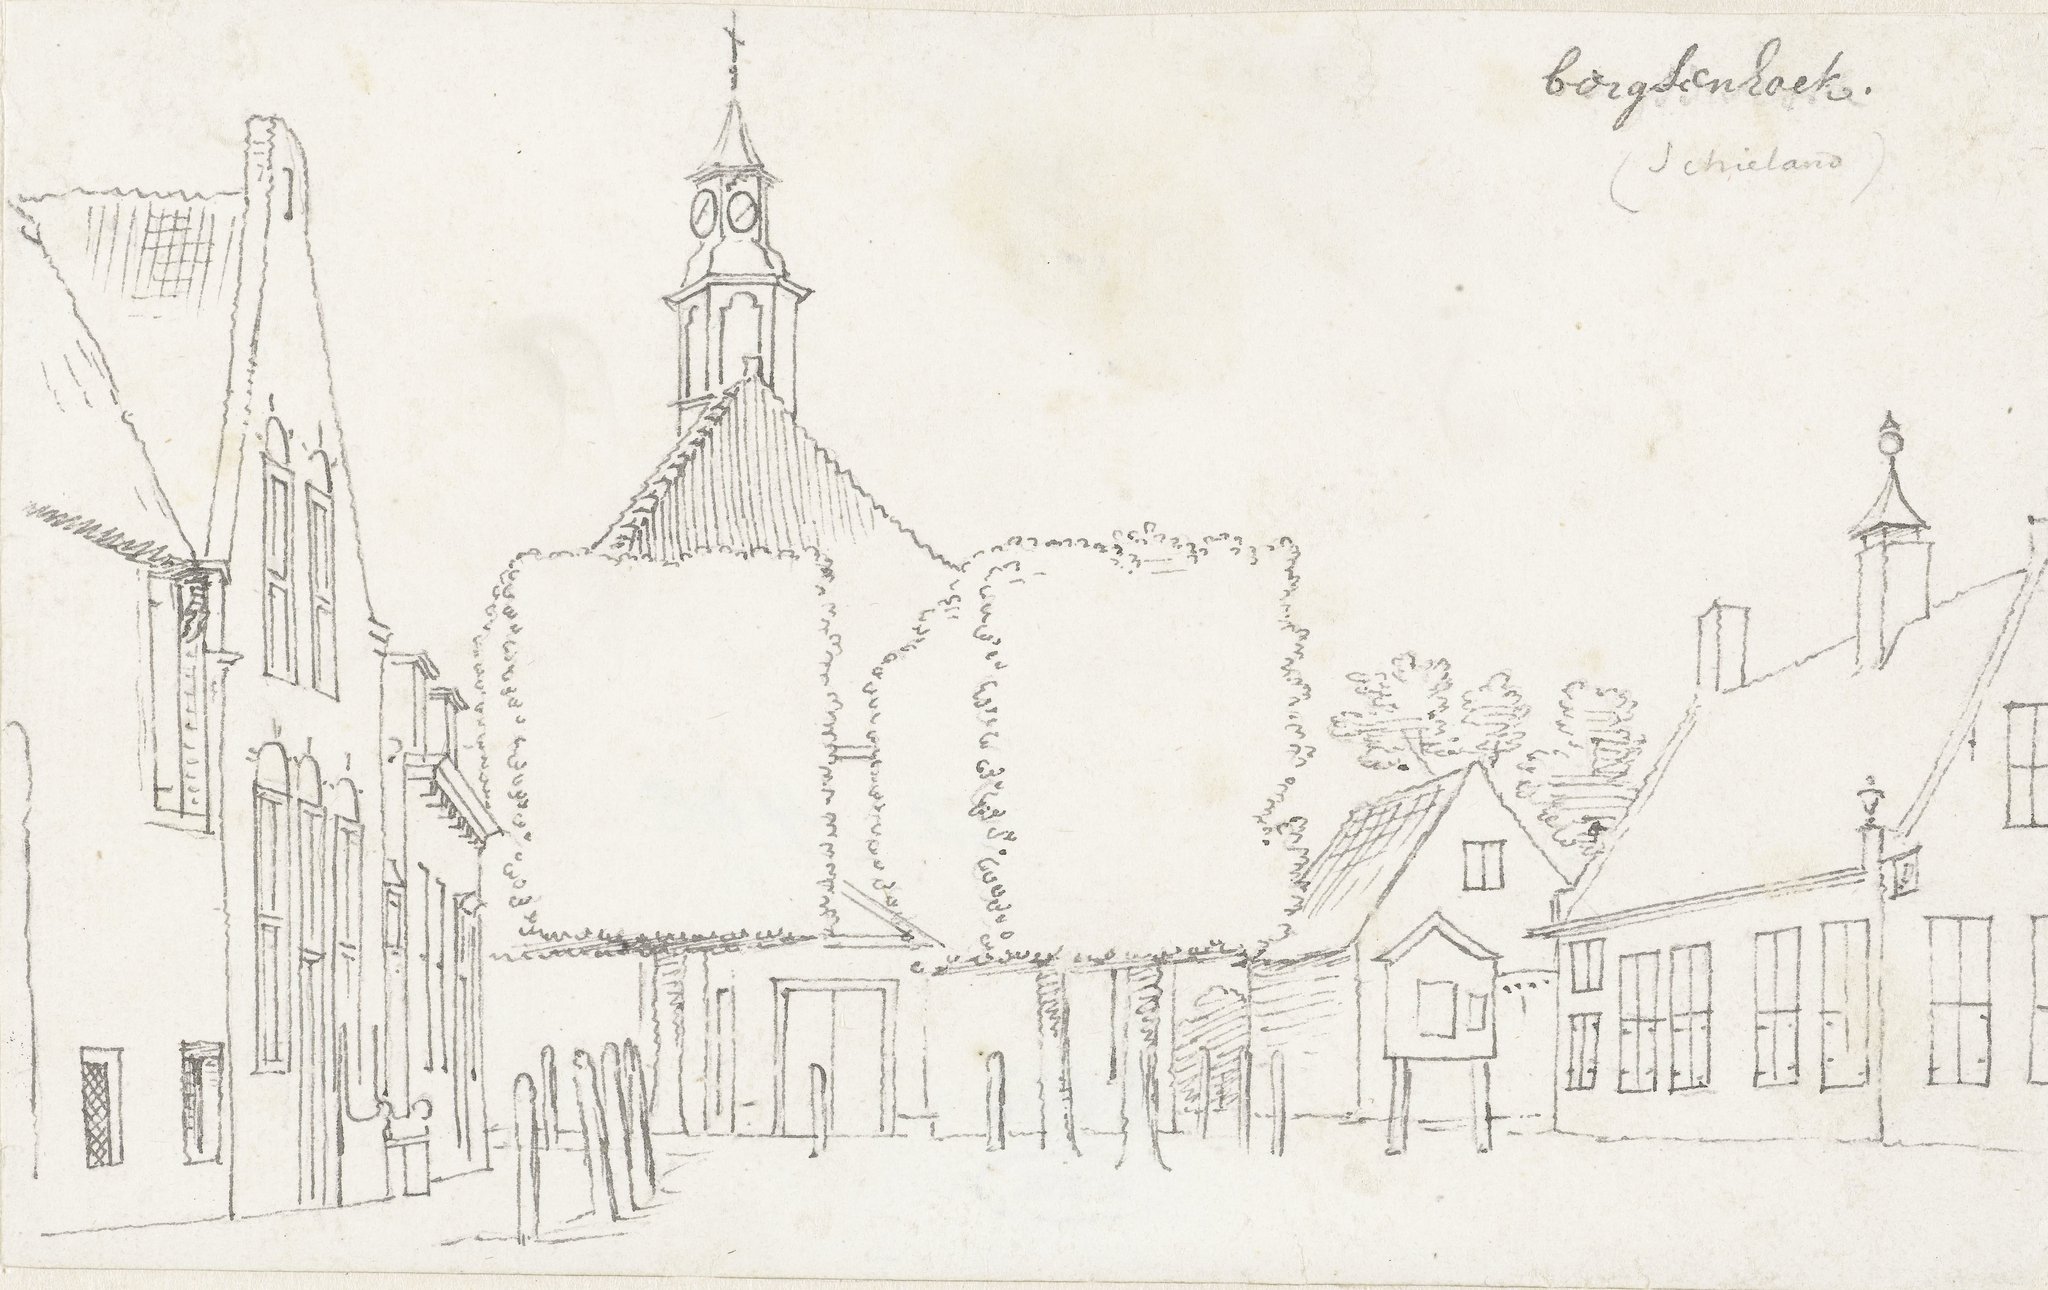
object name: drawing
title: Plein in Bergschenhoek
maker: cornelis pronk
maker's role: draughtsman, painter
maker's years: 1691-1759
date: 1720-1740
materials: ink, paper, pencil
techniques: pen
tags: church (exterior), street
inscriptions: inscription: ‘bergsenhoek. / (schieland)’